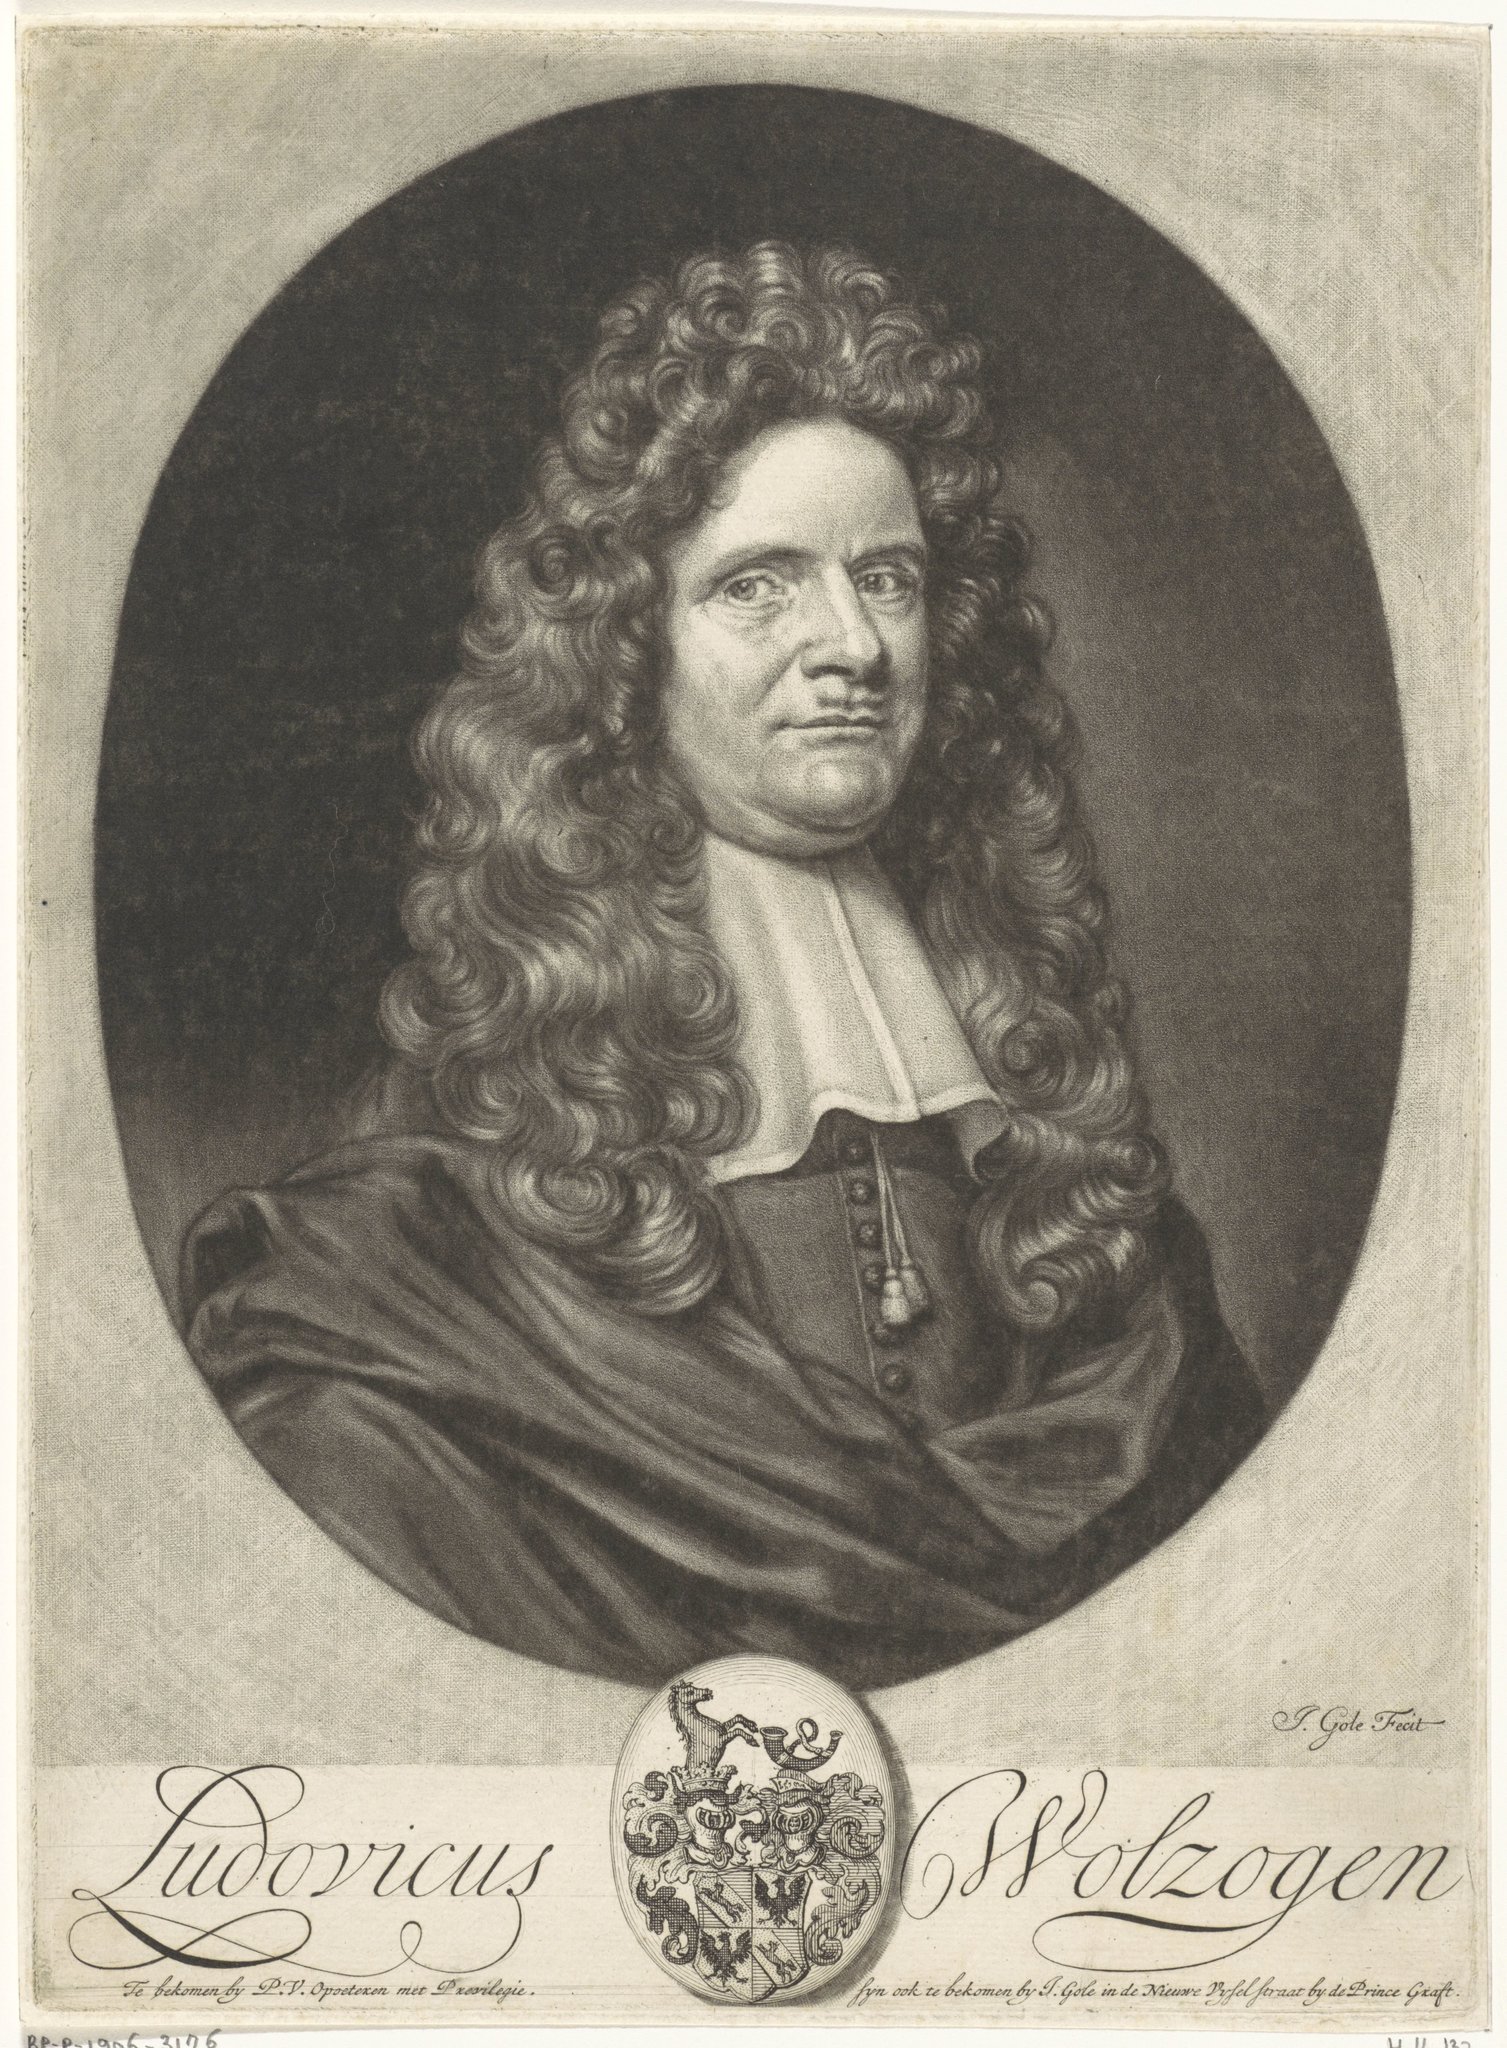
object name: print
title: Portret van Ludovicus Wolzogen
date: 1670-1724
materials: paper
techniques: engraving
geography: amsterdam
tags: armorial bearing, heraldry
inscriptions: collector's mark: Lugt 2228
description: Ludovicus Wolzogen, predikant en hoogleraar te Utrecht en Amsterdam. In de marge zijn naam en familiewapen.